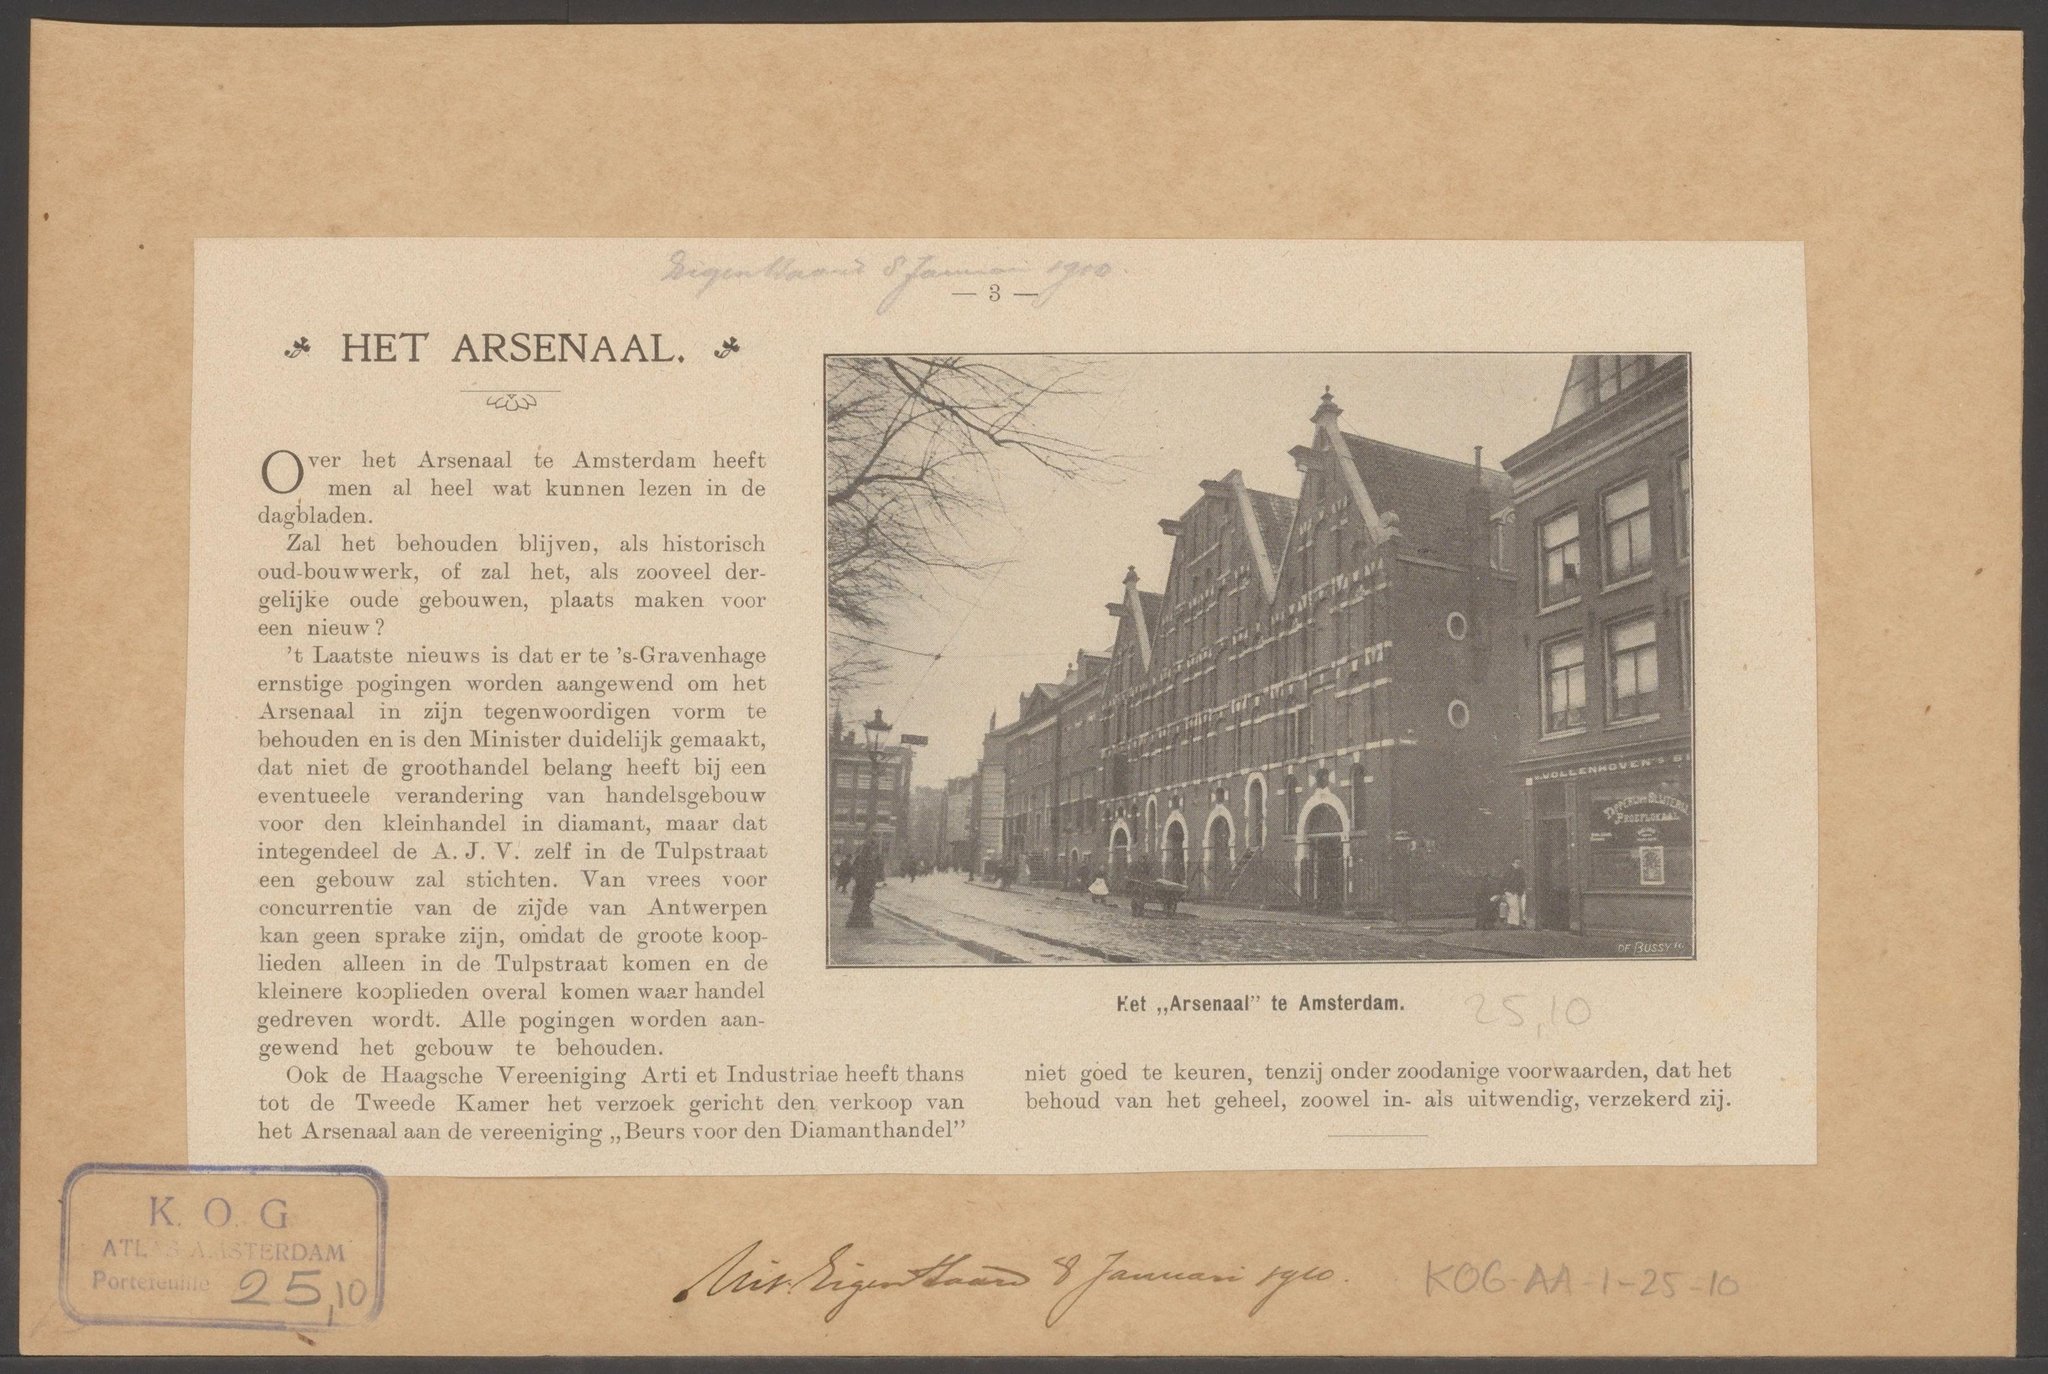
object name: photomechanical print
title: Arsenaal te Amsterdam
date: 1910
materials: paper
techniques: letterpress printing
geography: haarlem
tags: large-scale structure for storage, e.g.: warehouse, depot, silo, city-view in general; 'veduta', the usual house or row of houses, façade (of house or building)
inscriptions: collector's mark: ‘25.10’ Lugt 1641b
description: Onderwerpsrubriek binnen de Atlas Amsterdam: Krijgswezen I: De Admiraliteit van Amsterdam, A. Admiraliteitsgebouwen.